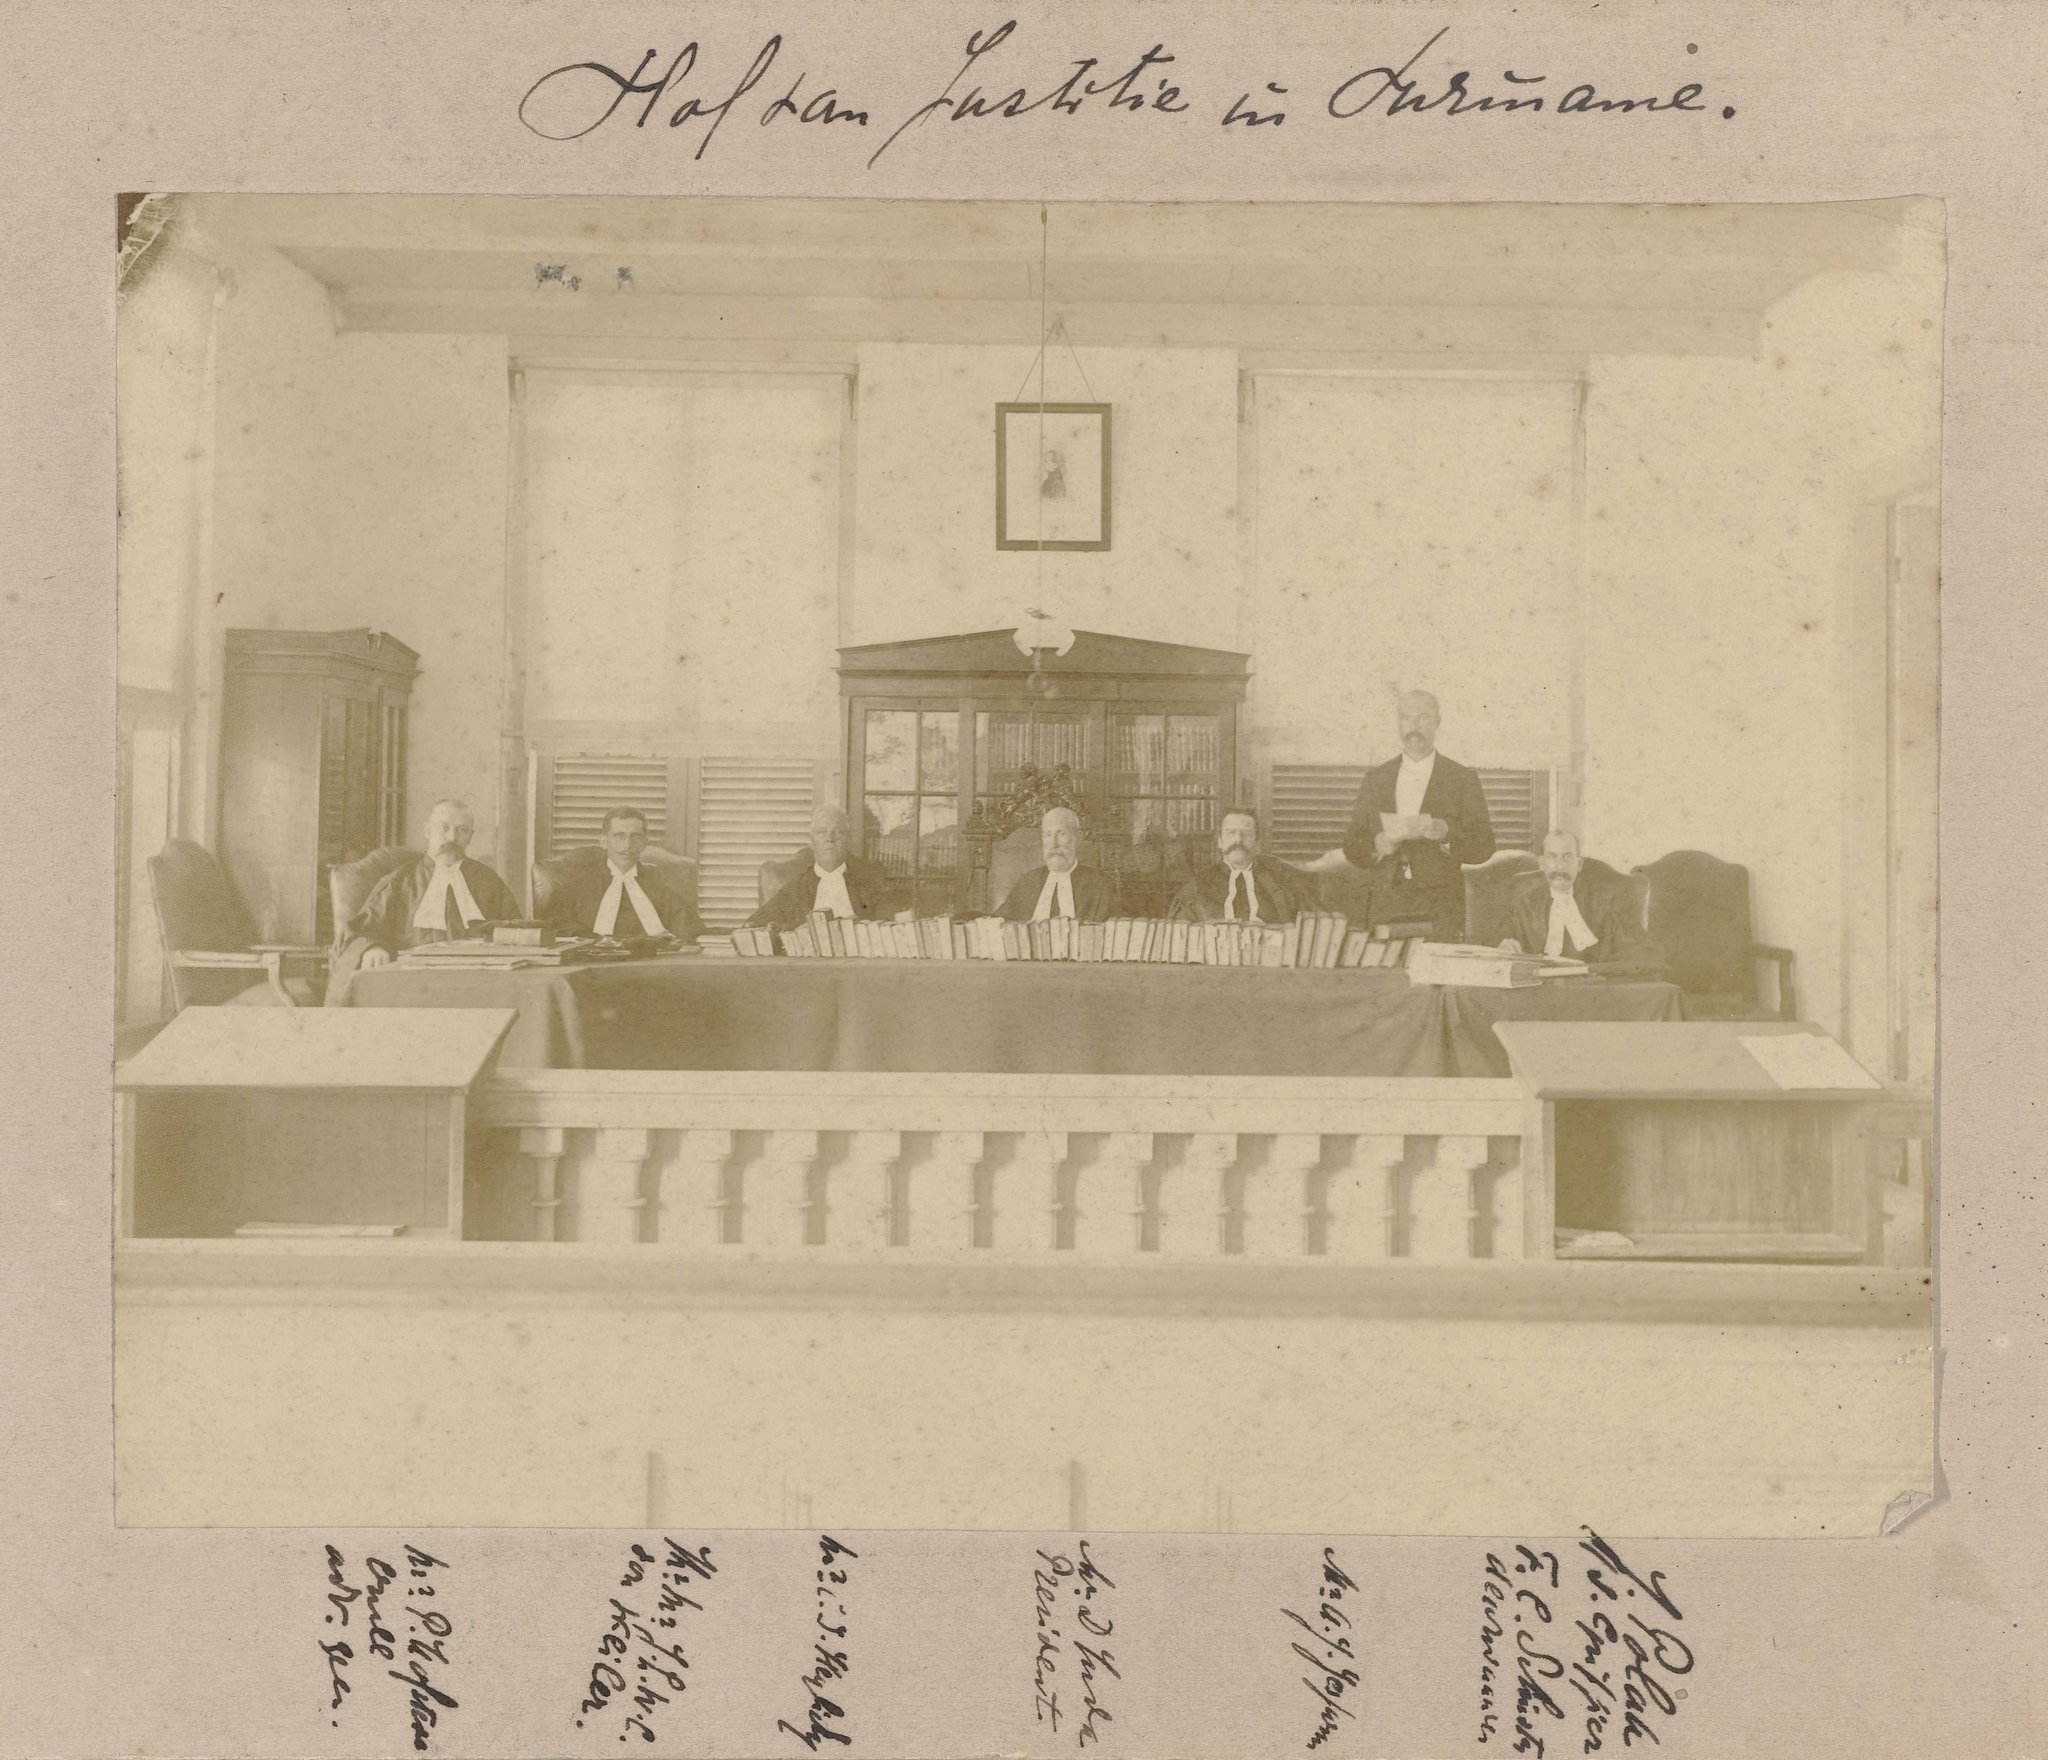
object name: photograph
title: Hof van Justitie in Suriname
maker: Anonymous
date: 1898-1903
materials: photographic support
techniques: photography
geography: paramaribo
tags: magistracy, judges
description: Achter een tafel zitten zeven heren, allen behorend tot het Hof van Justitie te Paramaribo in Suriname. Van links naar rechts: advocaat-generaal Mr. P. Hofstede Crull, Jhr Mr. J.L.W.C. von Weiler, Mr. C.J. Heylidy, Mr. D. Juda (president), Mr. A.J. Jessurun, F.J. Schuster (deurwaarder), J. Polak (griffier).